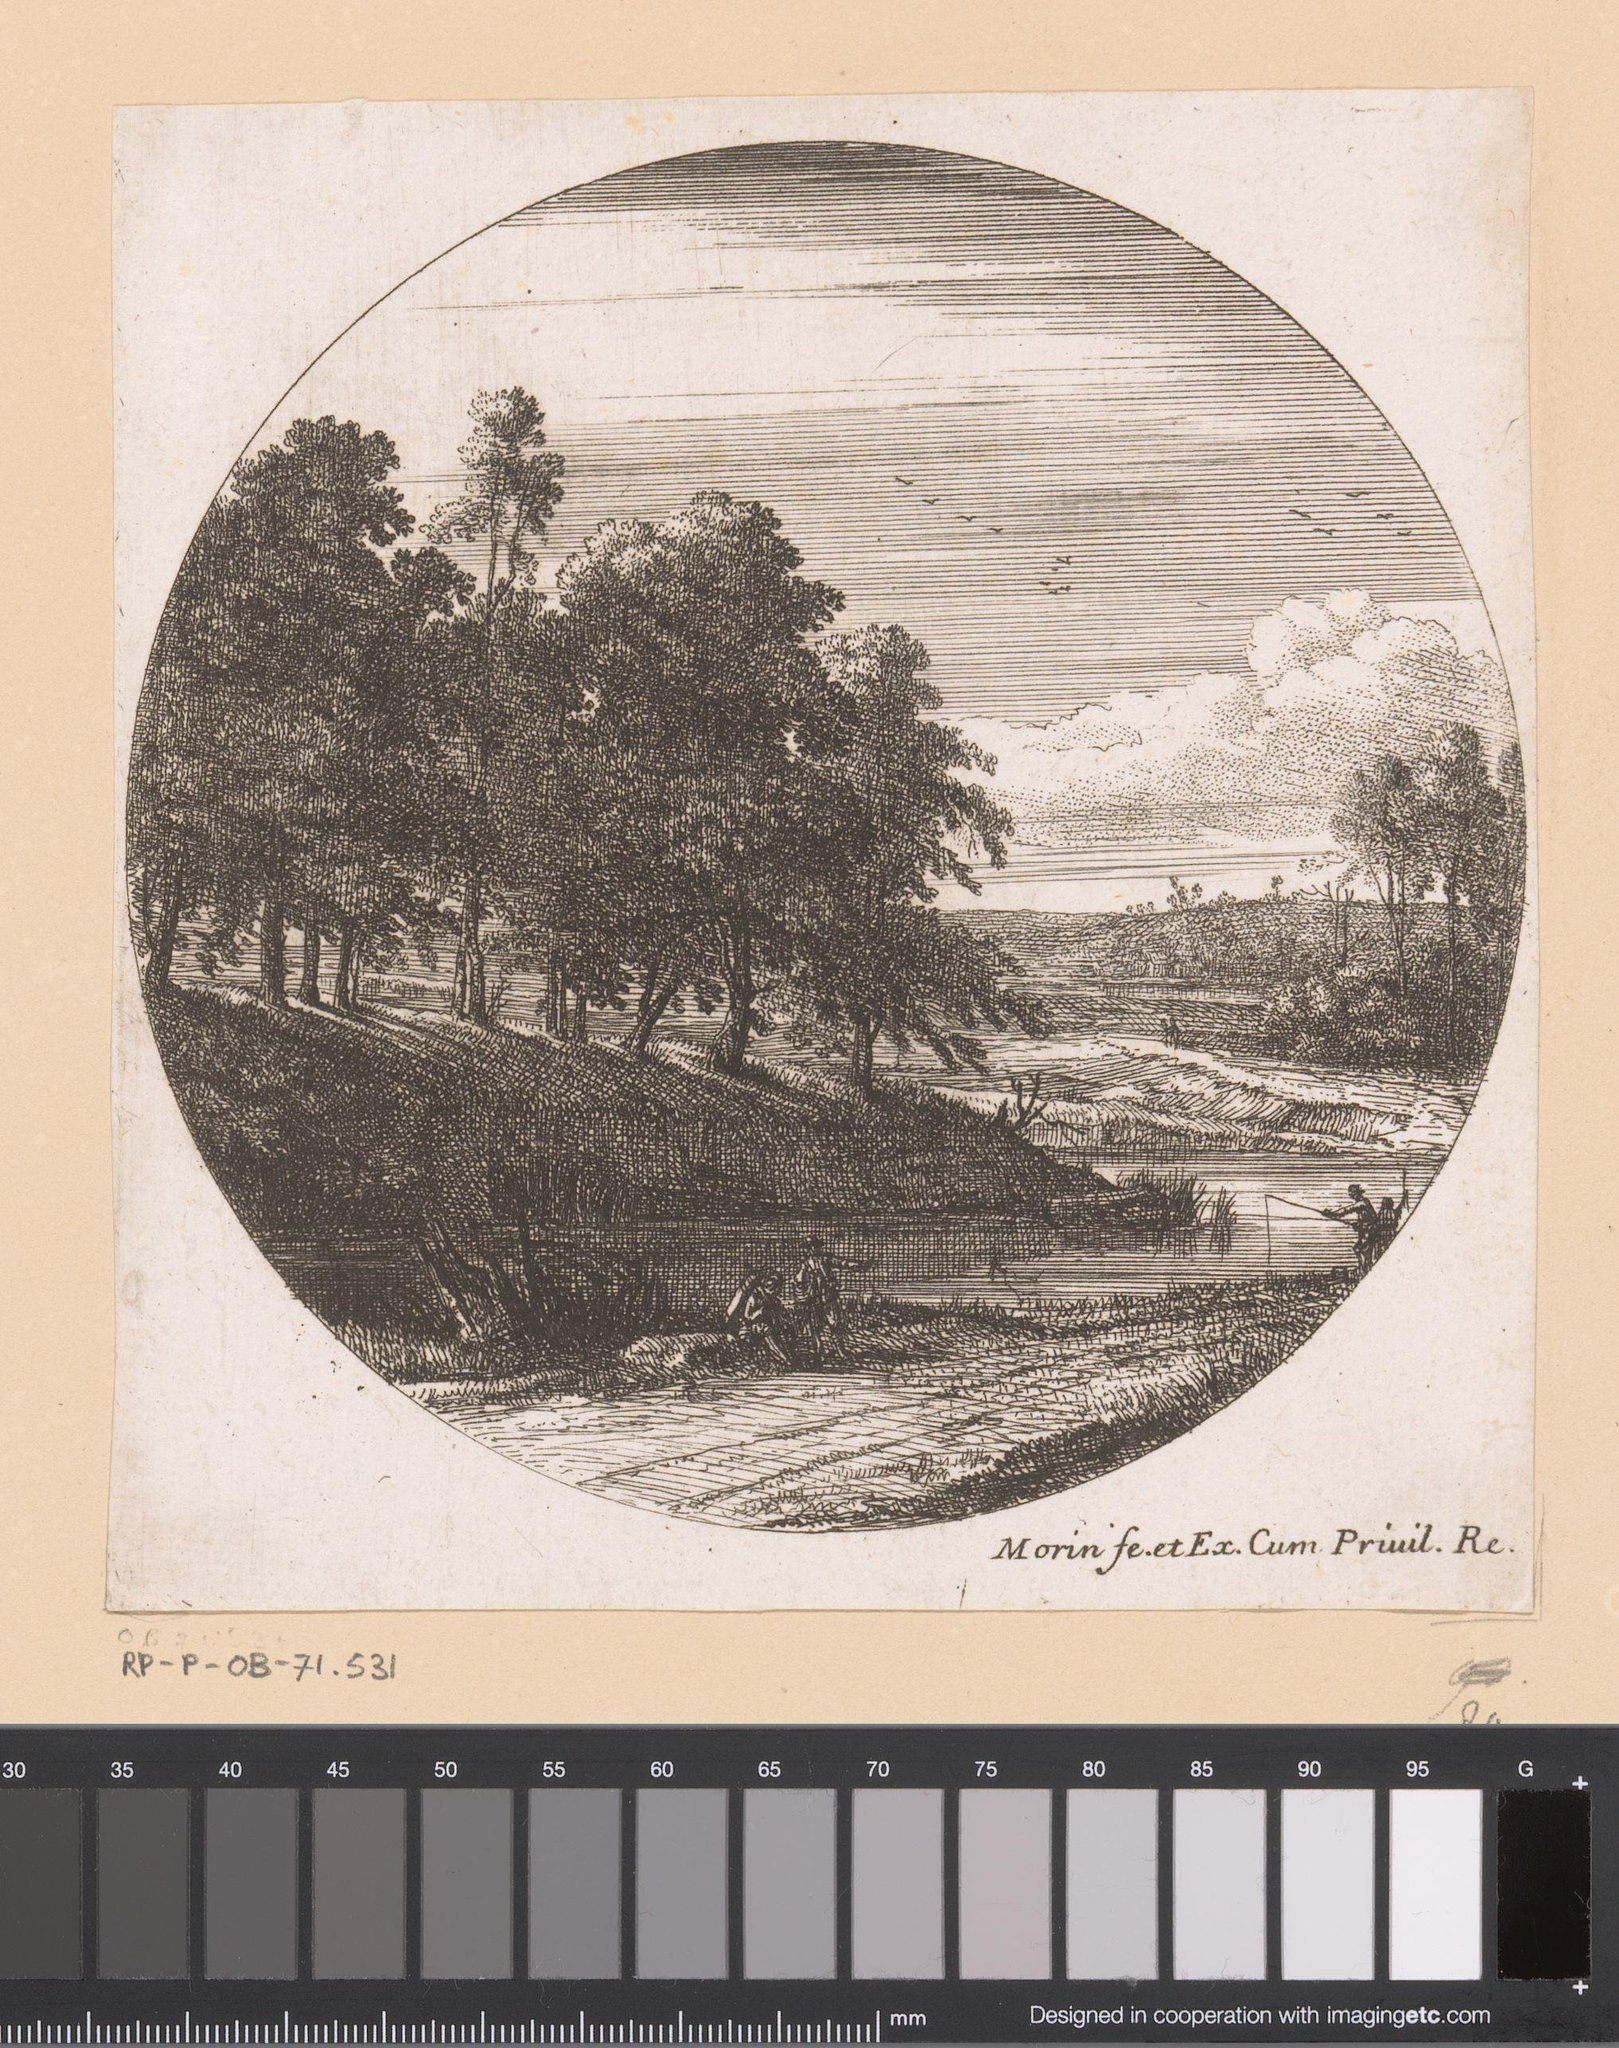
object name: print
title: Landschappen in cirkels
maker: jean morin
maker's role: print maker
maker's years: 1605-1650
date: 1625-1650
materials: paper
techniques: etching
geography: france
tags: road, path, landscapes in the temperate zone (+ landscape with figures, staffage)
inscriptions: collector's mark: Lugt 240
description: Maakt deel uit van een zesdelige serie met landschappen in cirkels, uitgegeven door Morin.